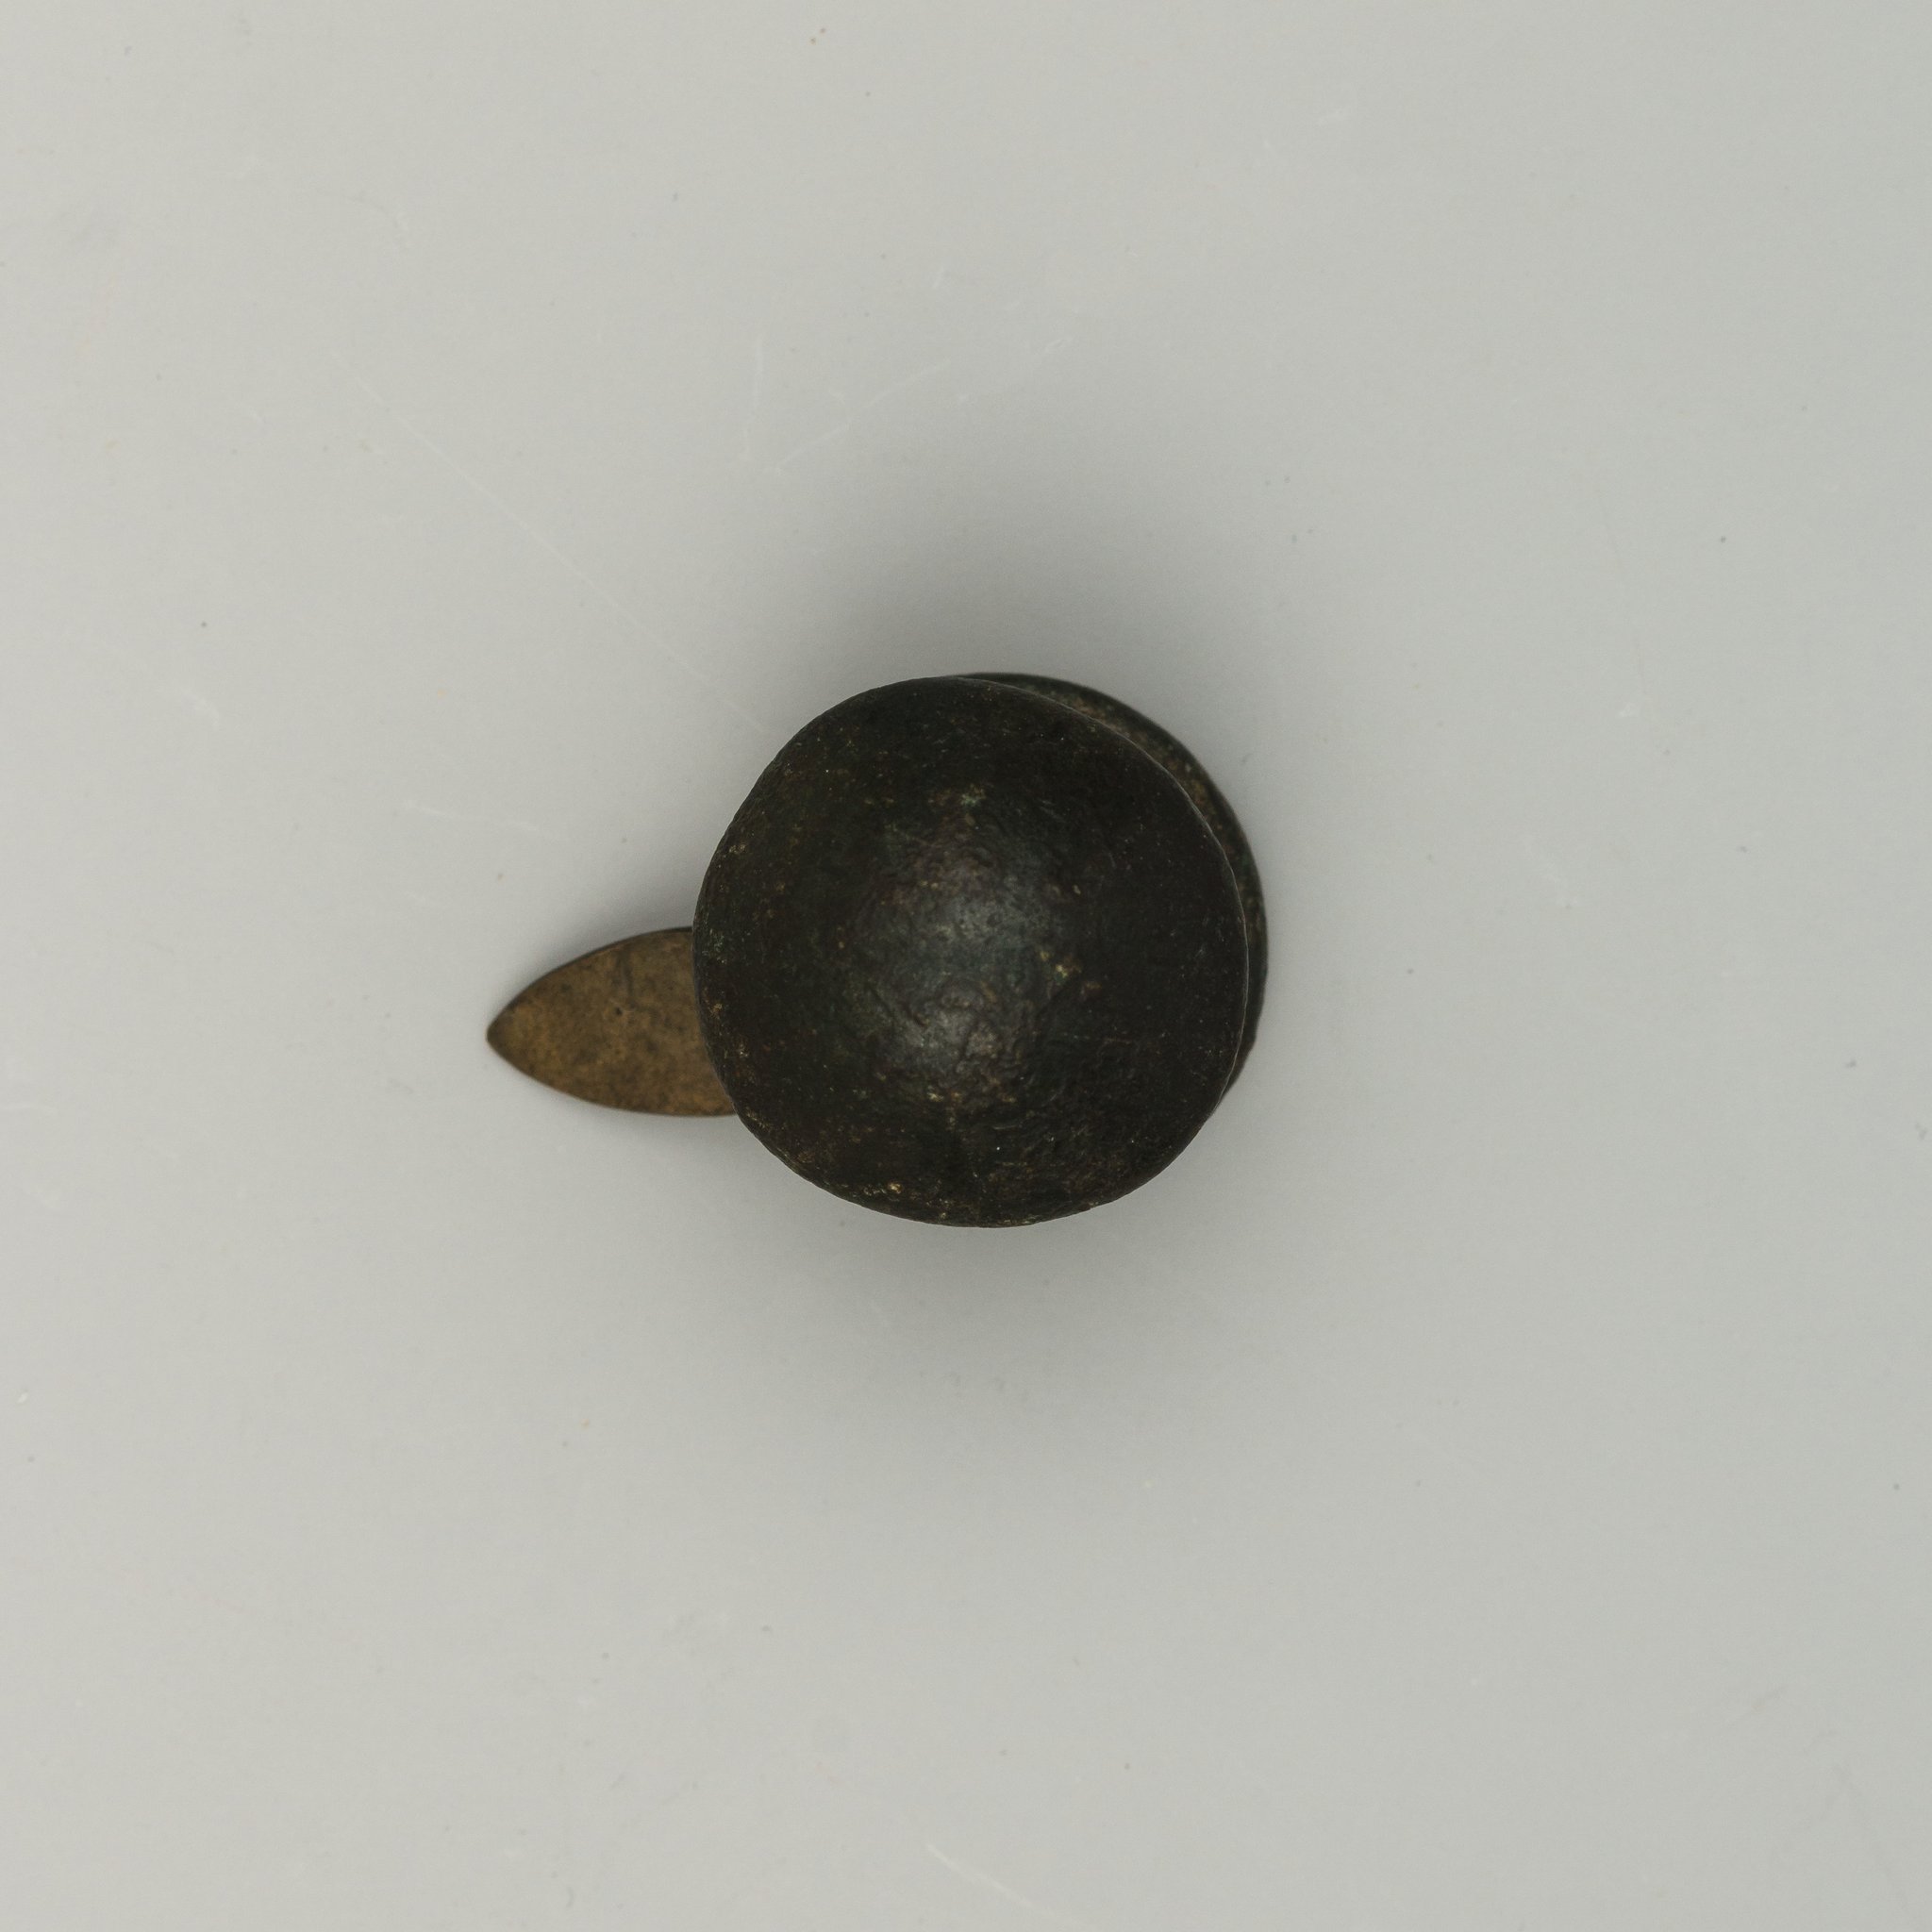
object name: button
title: Button, maybe for a Horse Tack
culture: roman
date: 1-400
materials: copper alloy